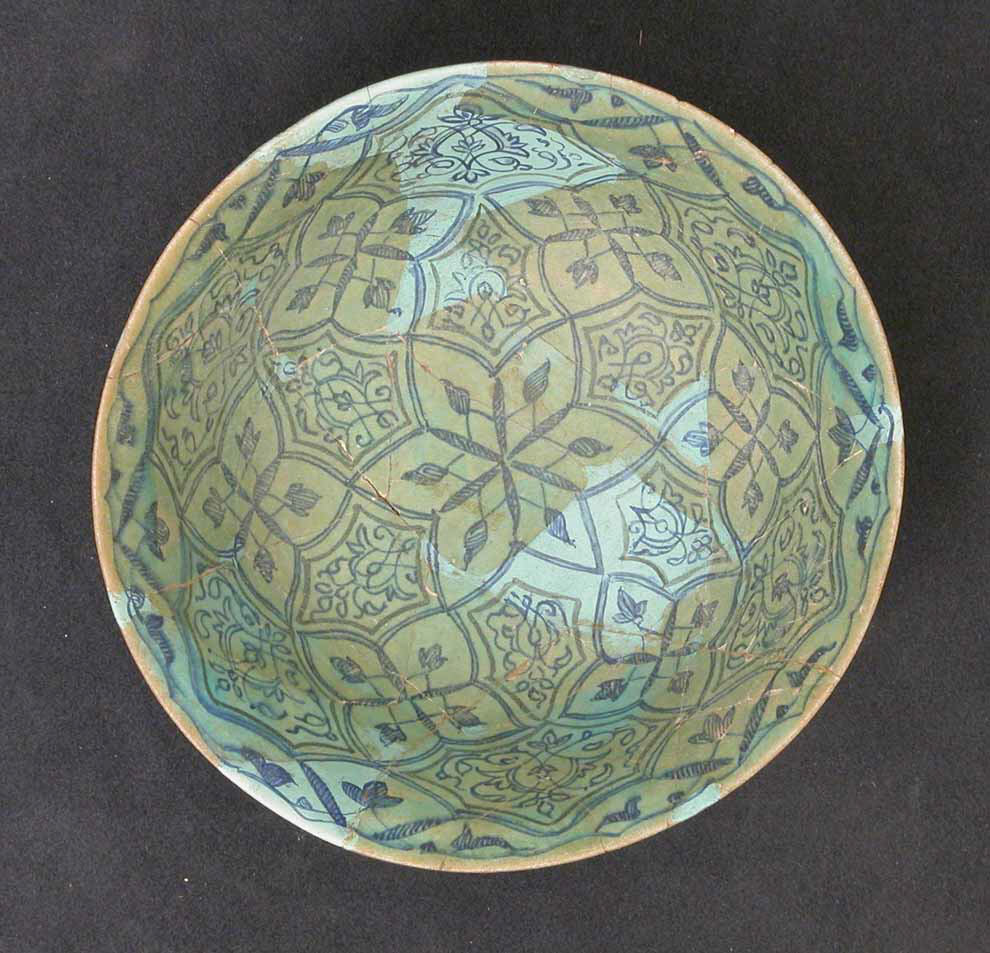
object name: bowl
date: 1301-1500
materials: earthenware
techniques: glazing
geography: iran